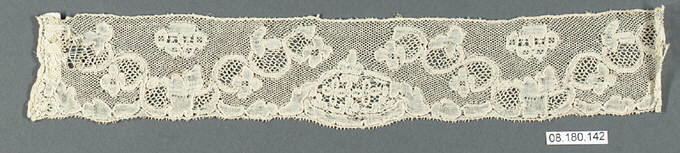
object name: piece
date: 1701-1800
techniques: lace